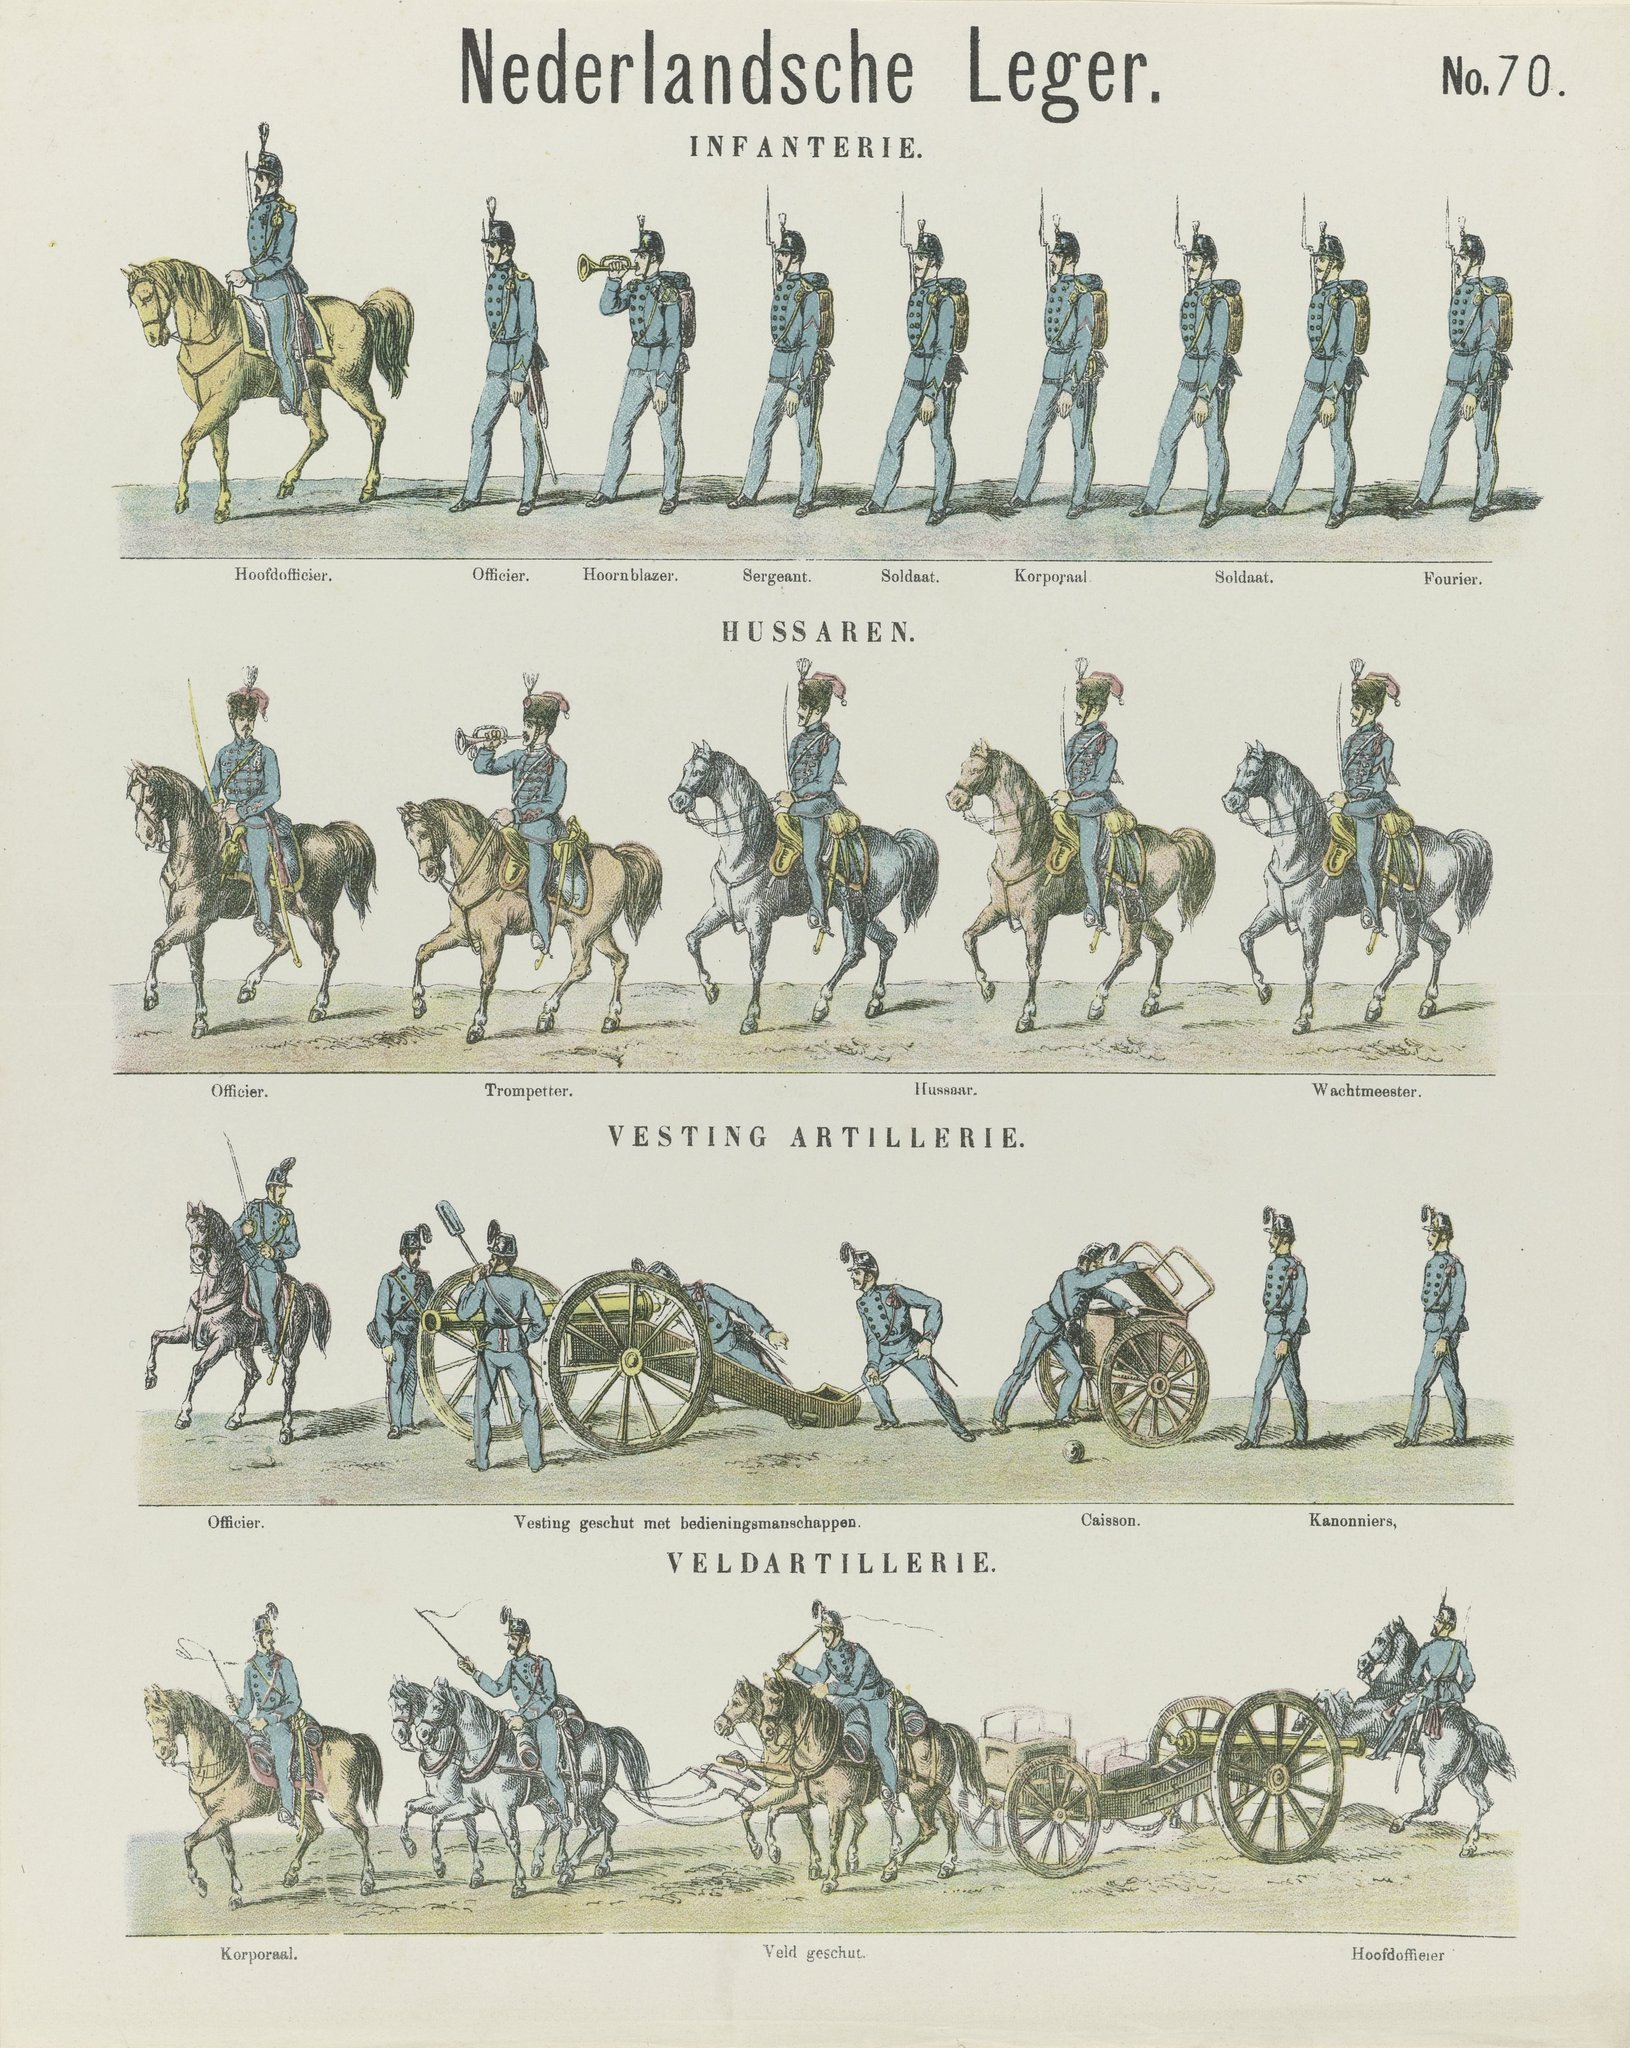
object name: print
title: Nederlandsche leger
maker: Anonymous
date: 1878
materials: paper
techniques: lithograph, letterpress printing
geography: amsterdam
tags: warfare; military affairs (+ cavalry, horsemen), the soldier; the soldier's life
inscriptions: collector's mark: Lugt 2760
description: Blad met 4 horizontale rijen met voorstellingen van Nederlandse militairen. Onder elke afbeelding een onderschrift. Genummerd rechtsboven: No. 70.